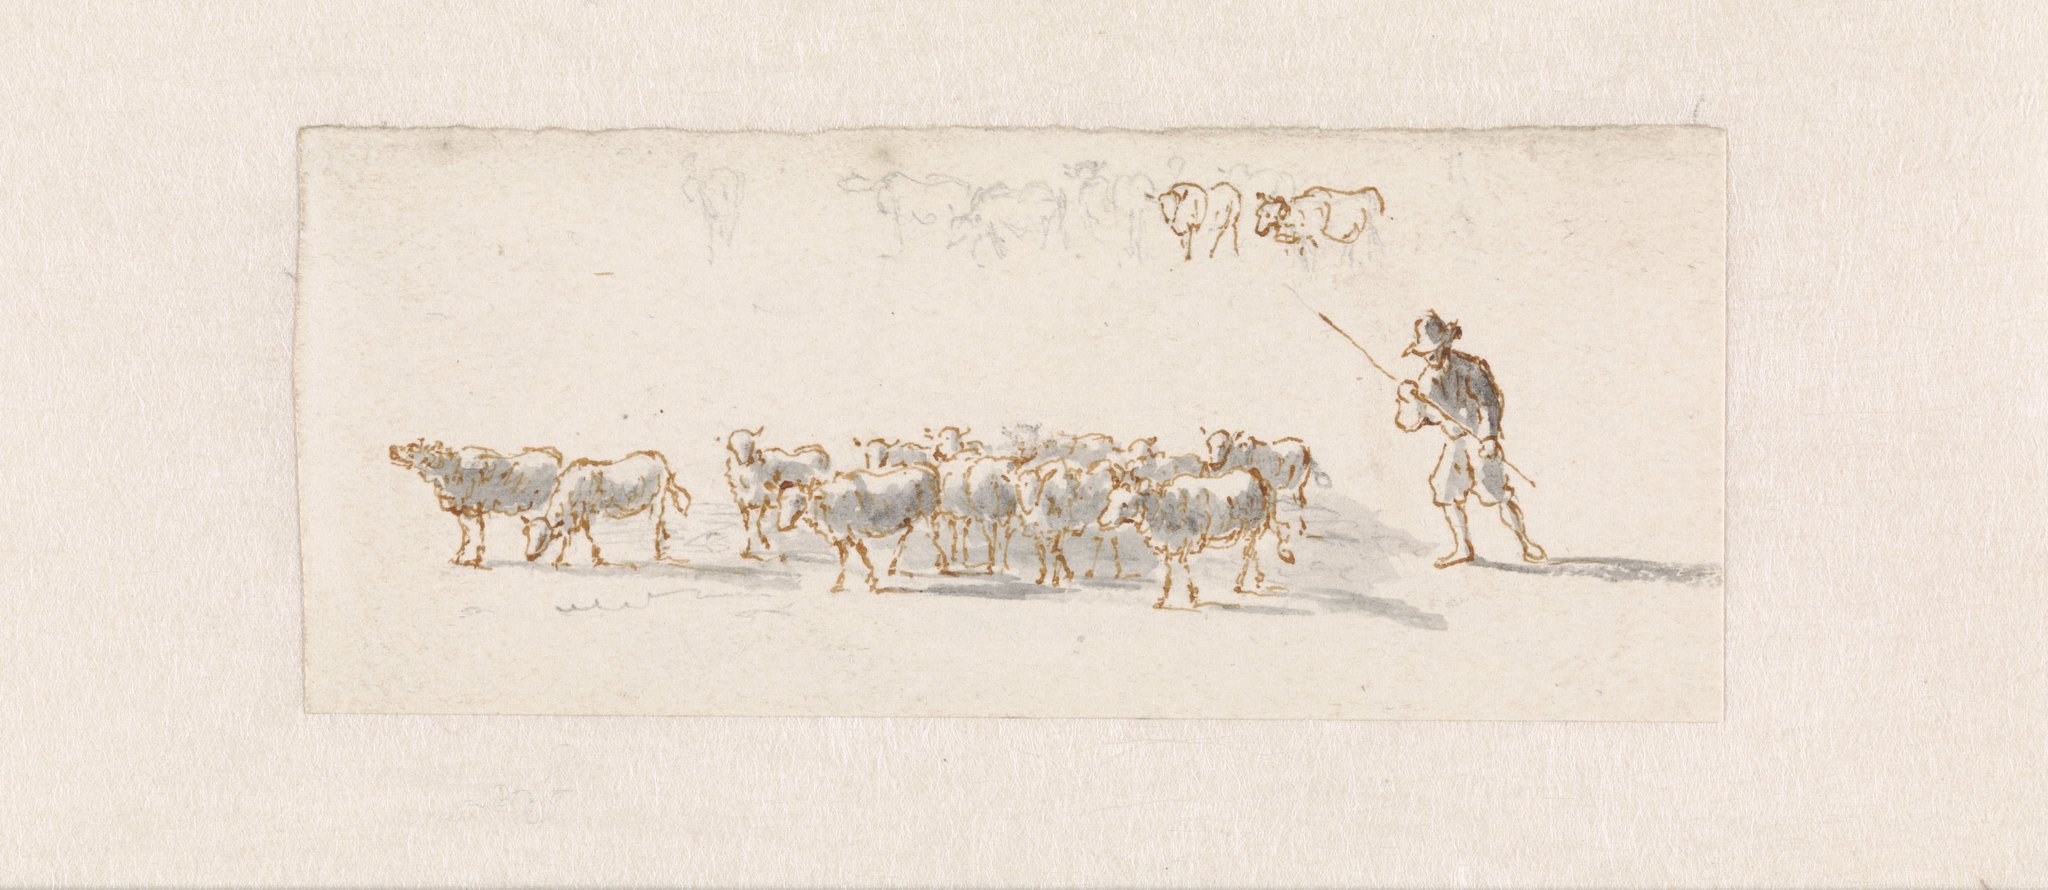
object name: drawing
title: Schetsblad met herder met schapen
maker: gerardus emaus de micault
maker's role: draughtsman, print maker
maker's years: 1798-1863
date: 1799-1863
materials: ink, paper, pencil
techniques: brush, pen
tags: herd, flock